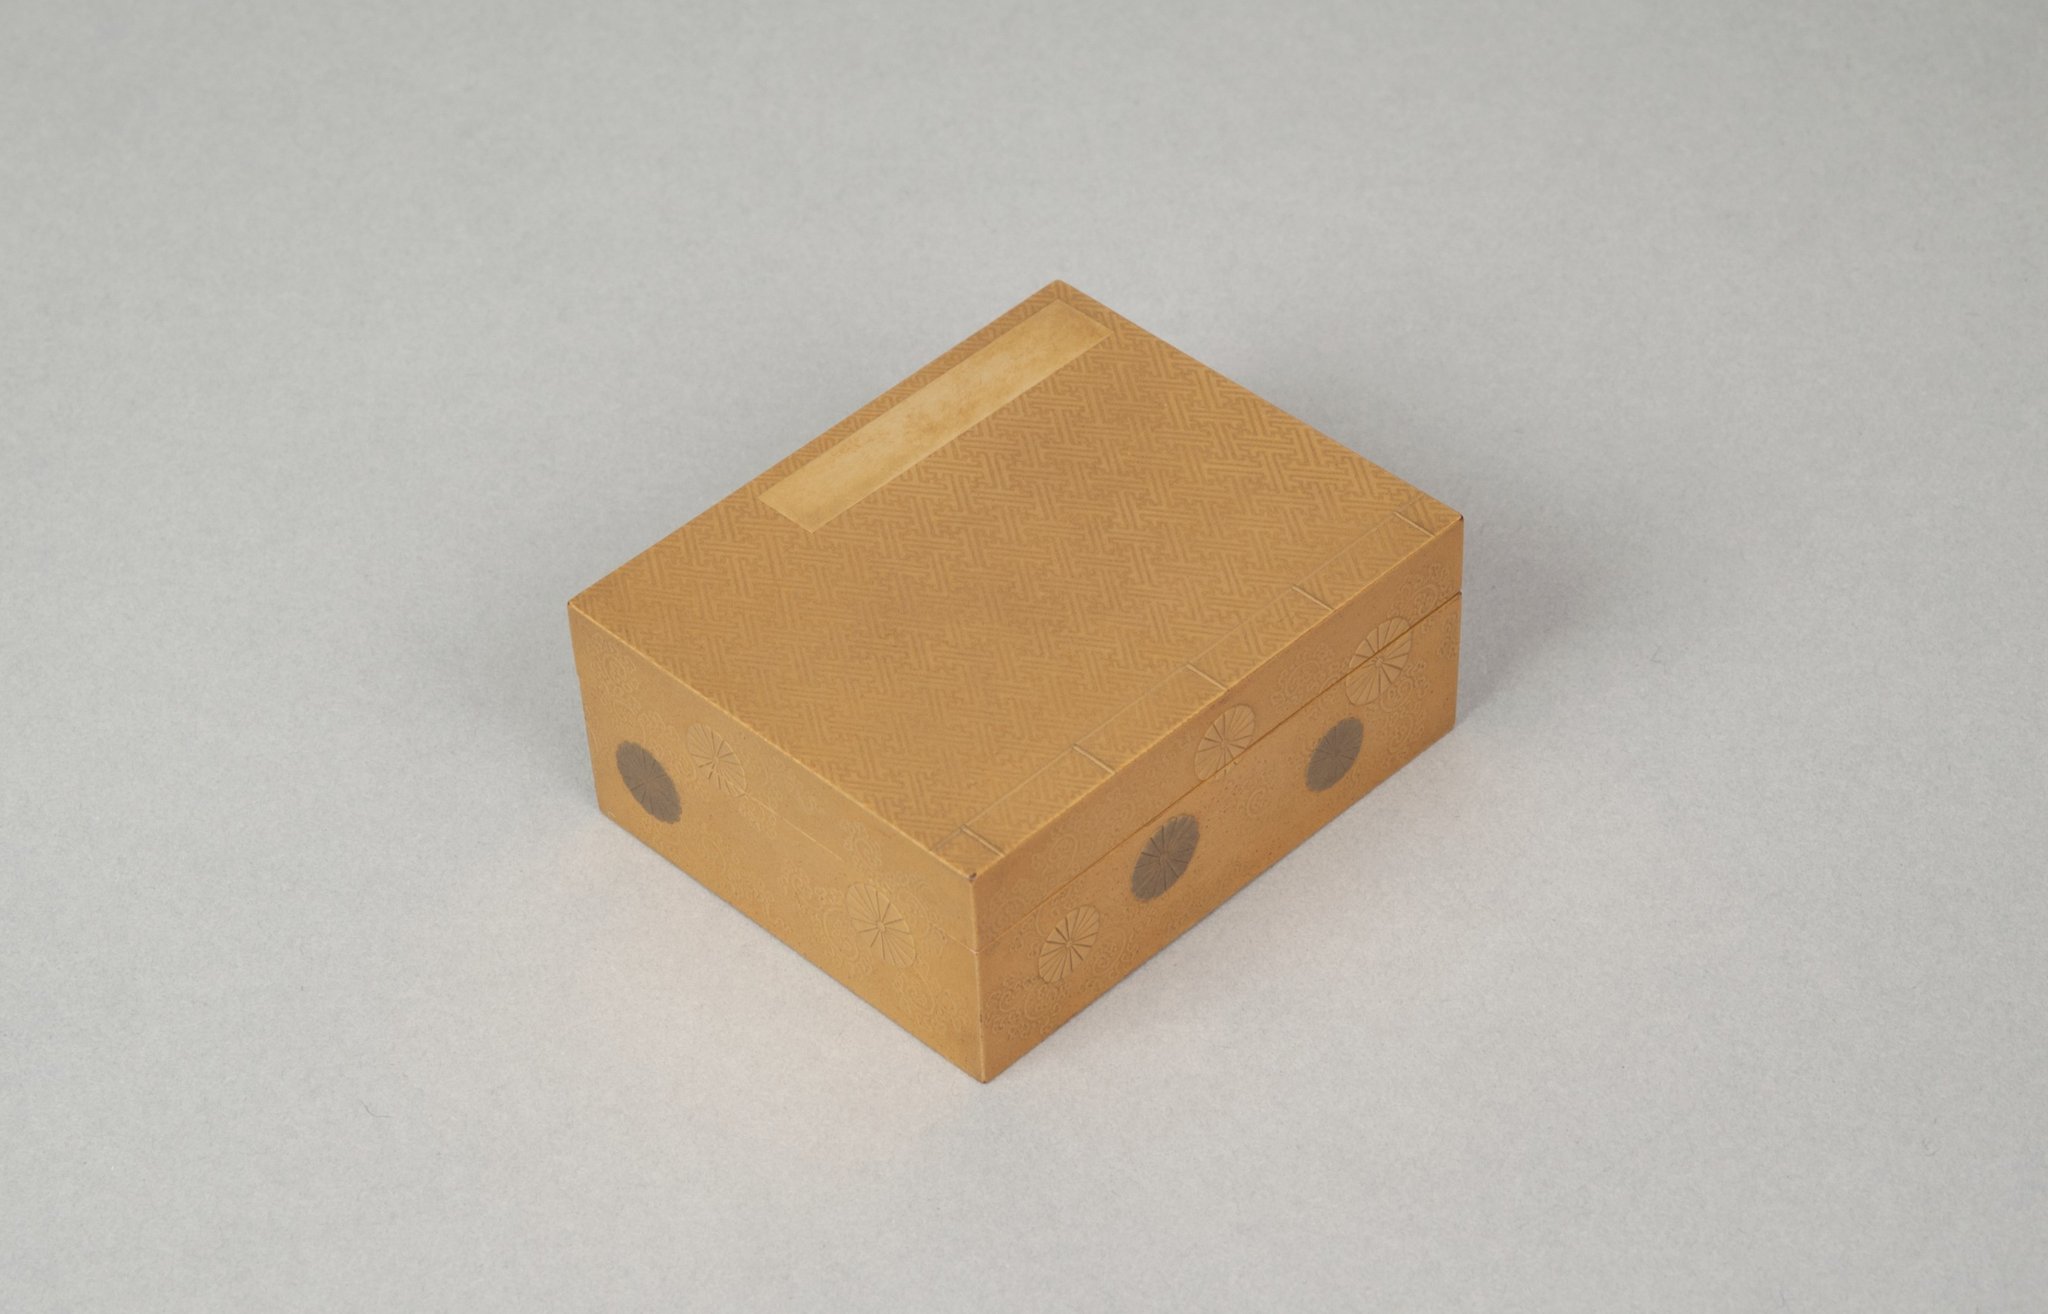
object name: incense box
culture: japanese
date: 1834-1866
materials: lacquer